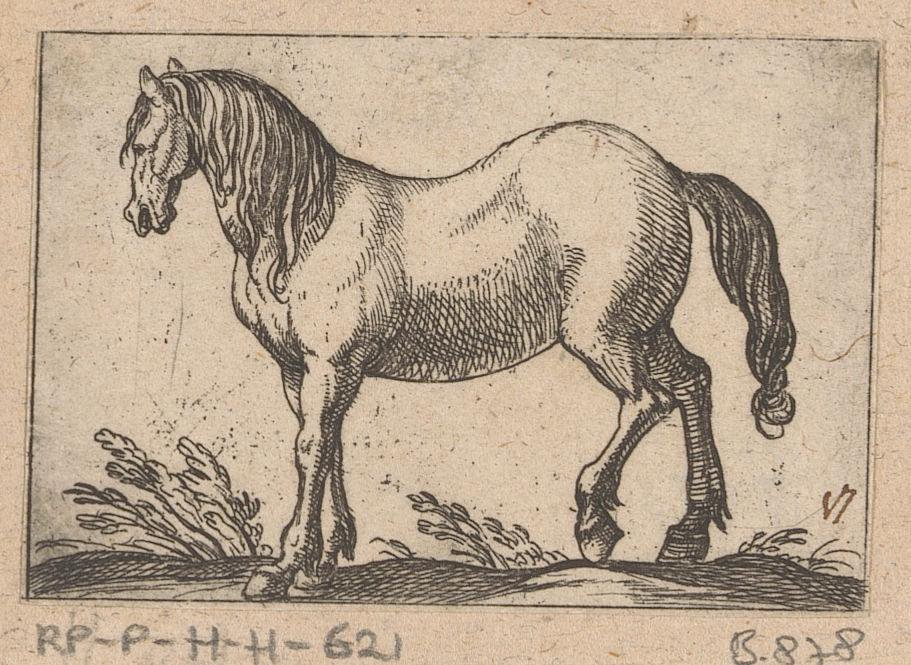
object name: print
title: Paarden in verschillende houdingen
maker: antonio tempesta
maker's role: draughtsman, painter, print maker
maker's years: 1555-1630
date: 1565-1630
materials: paper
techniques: etching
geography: italy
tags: horse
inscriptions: collector's mark: Lugt 11, number: ‘17’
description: Deze prent maakt deel uit van een reeks van 24 prenten van paarden.